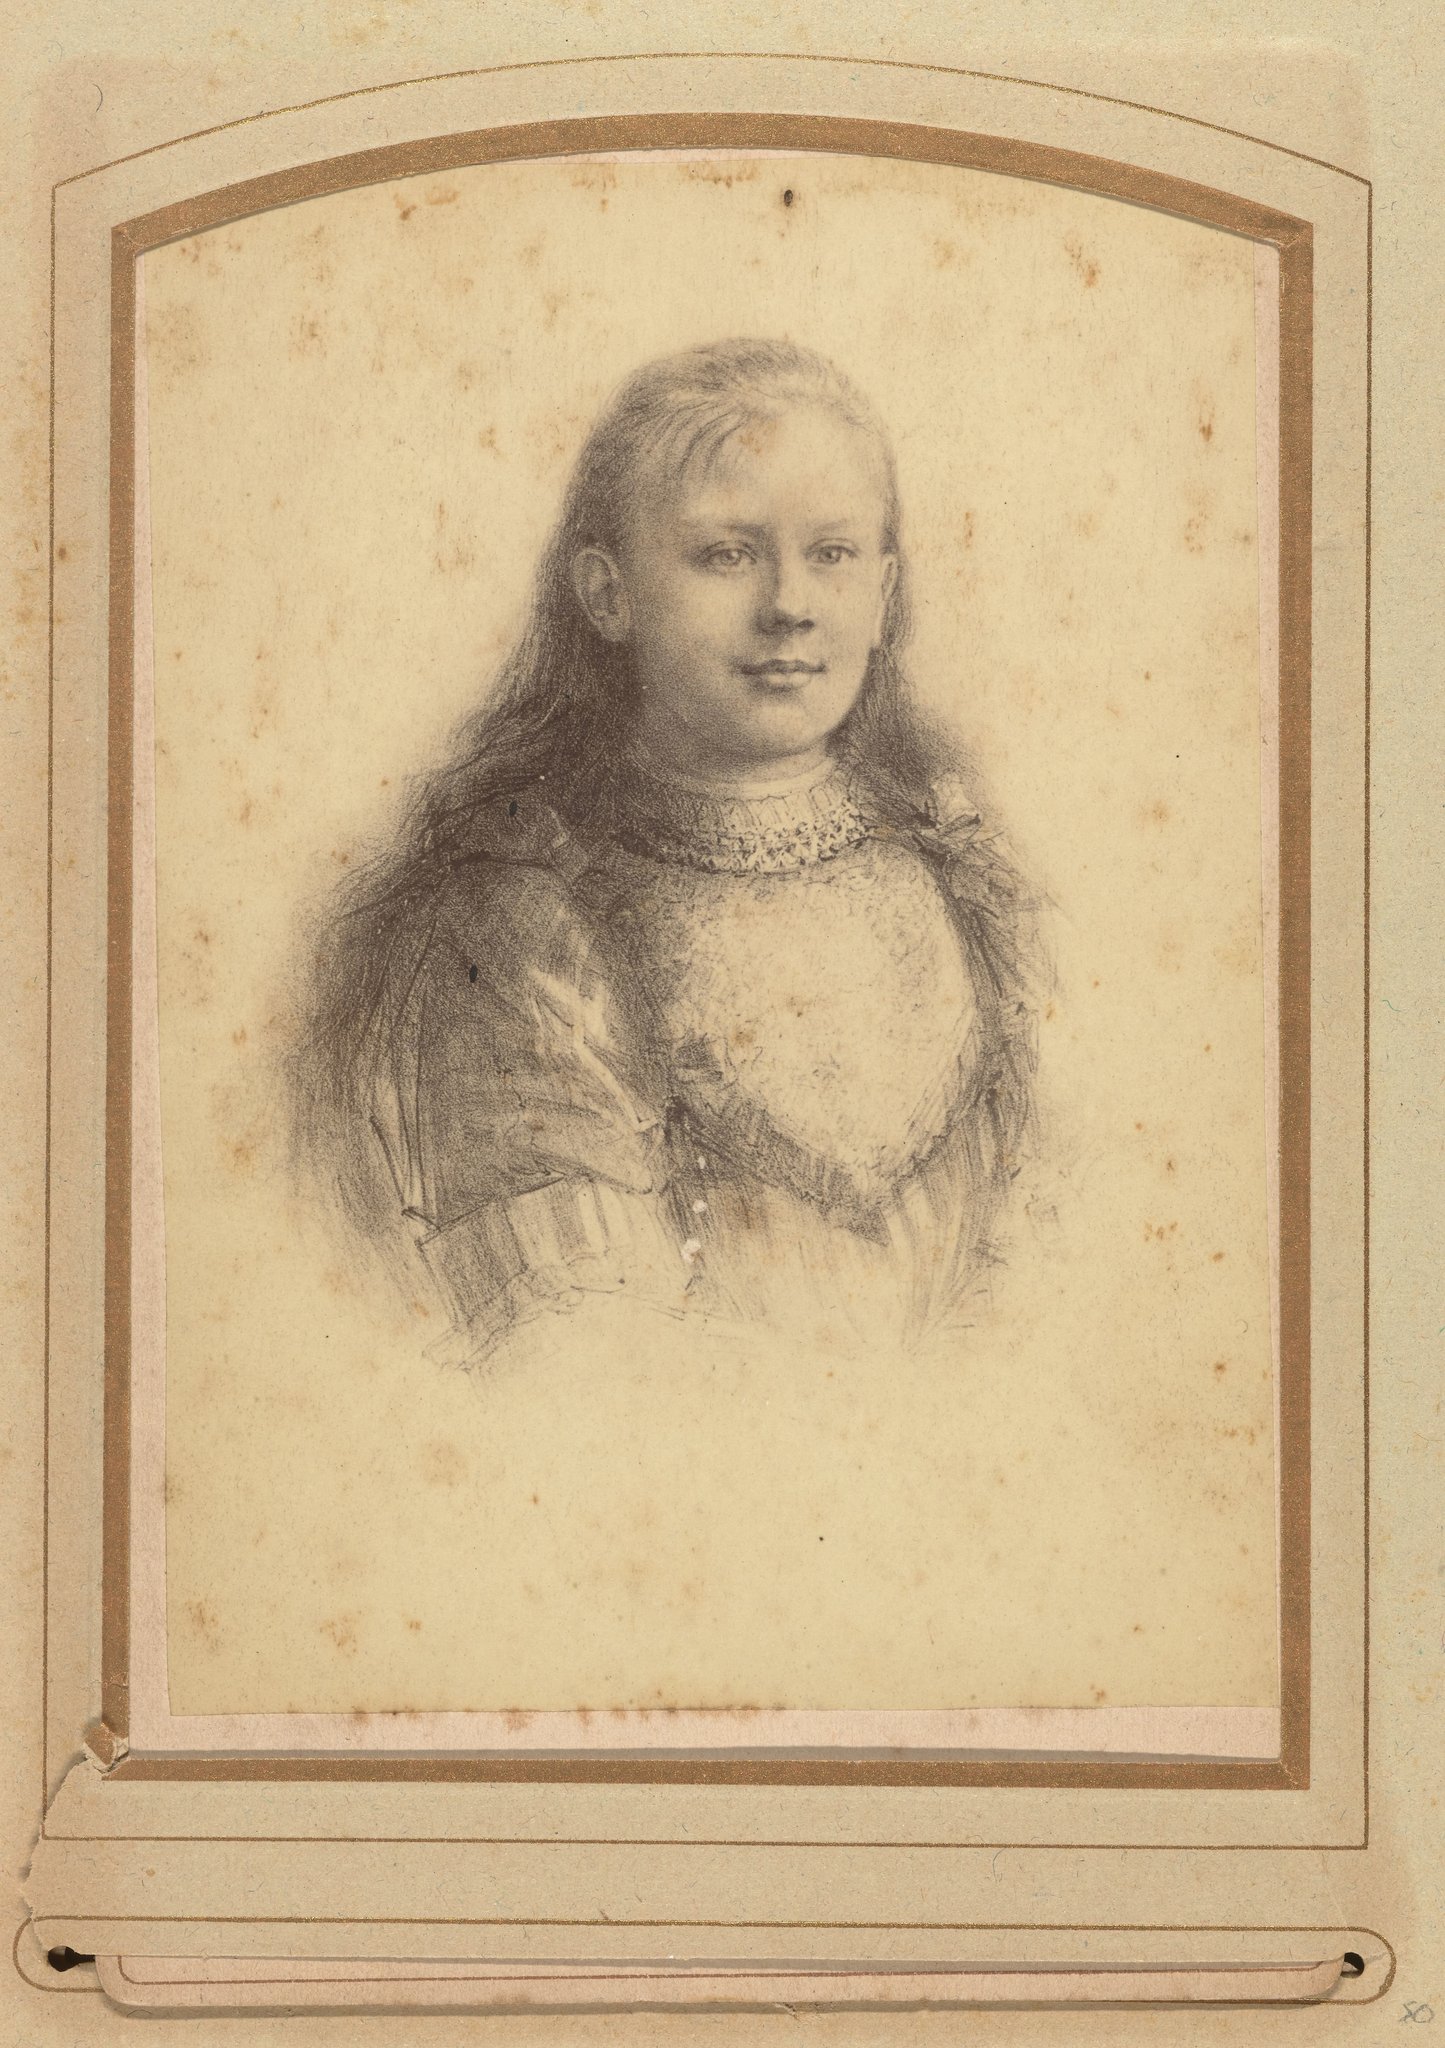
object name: carte de visite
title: Fotografische reproductie van een getekend portret van prinses Wilhelmina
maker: antoine johan marinus steinmetz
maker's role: fotograaf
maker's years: 1867-1950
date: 1890-1910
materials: paper, photographic support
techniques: photography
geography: the hague